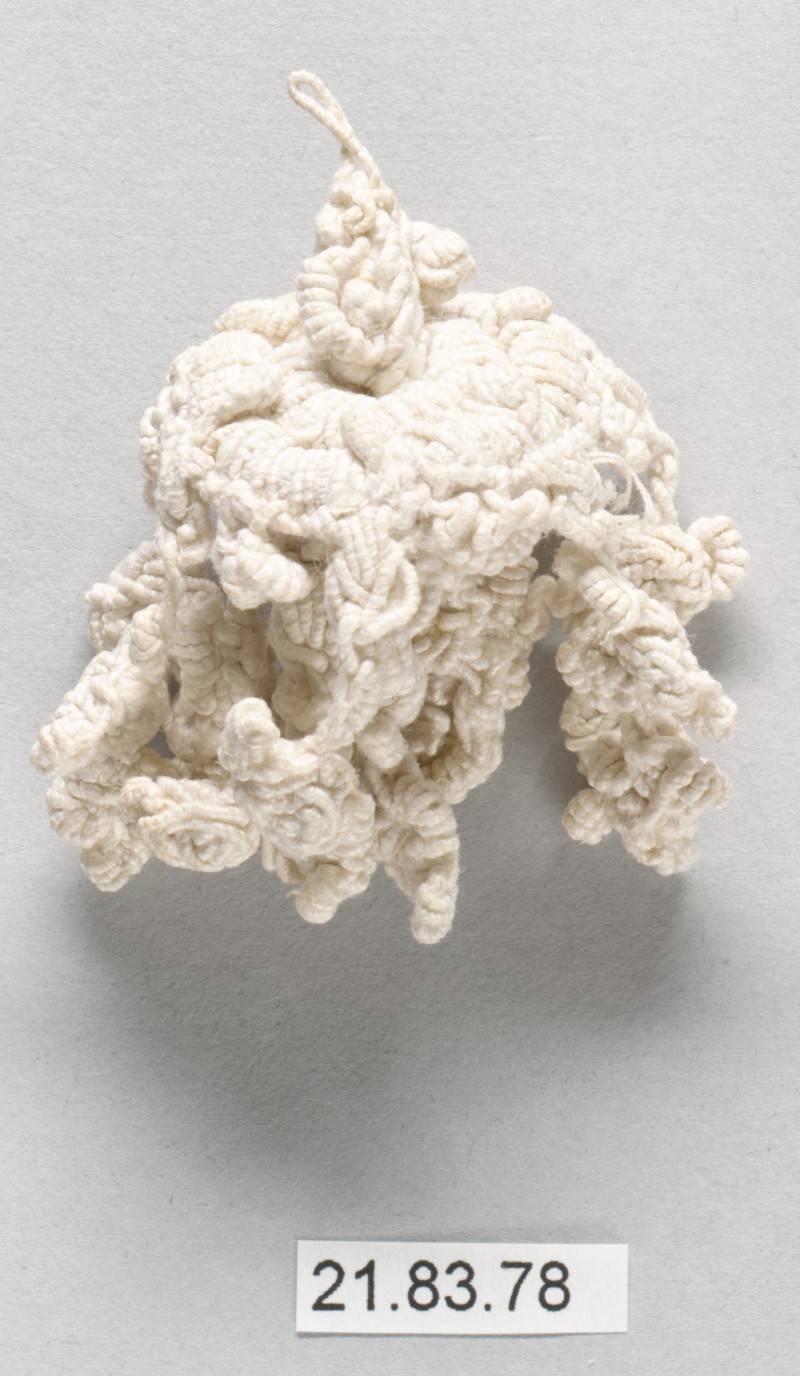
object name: tassel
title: Pair of tassels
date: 1601-1700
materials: linen